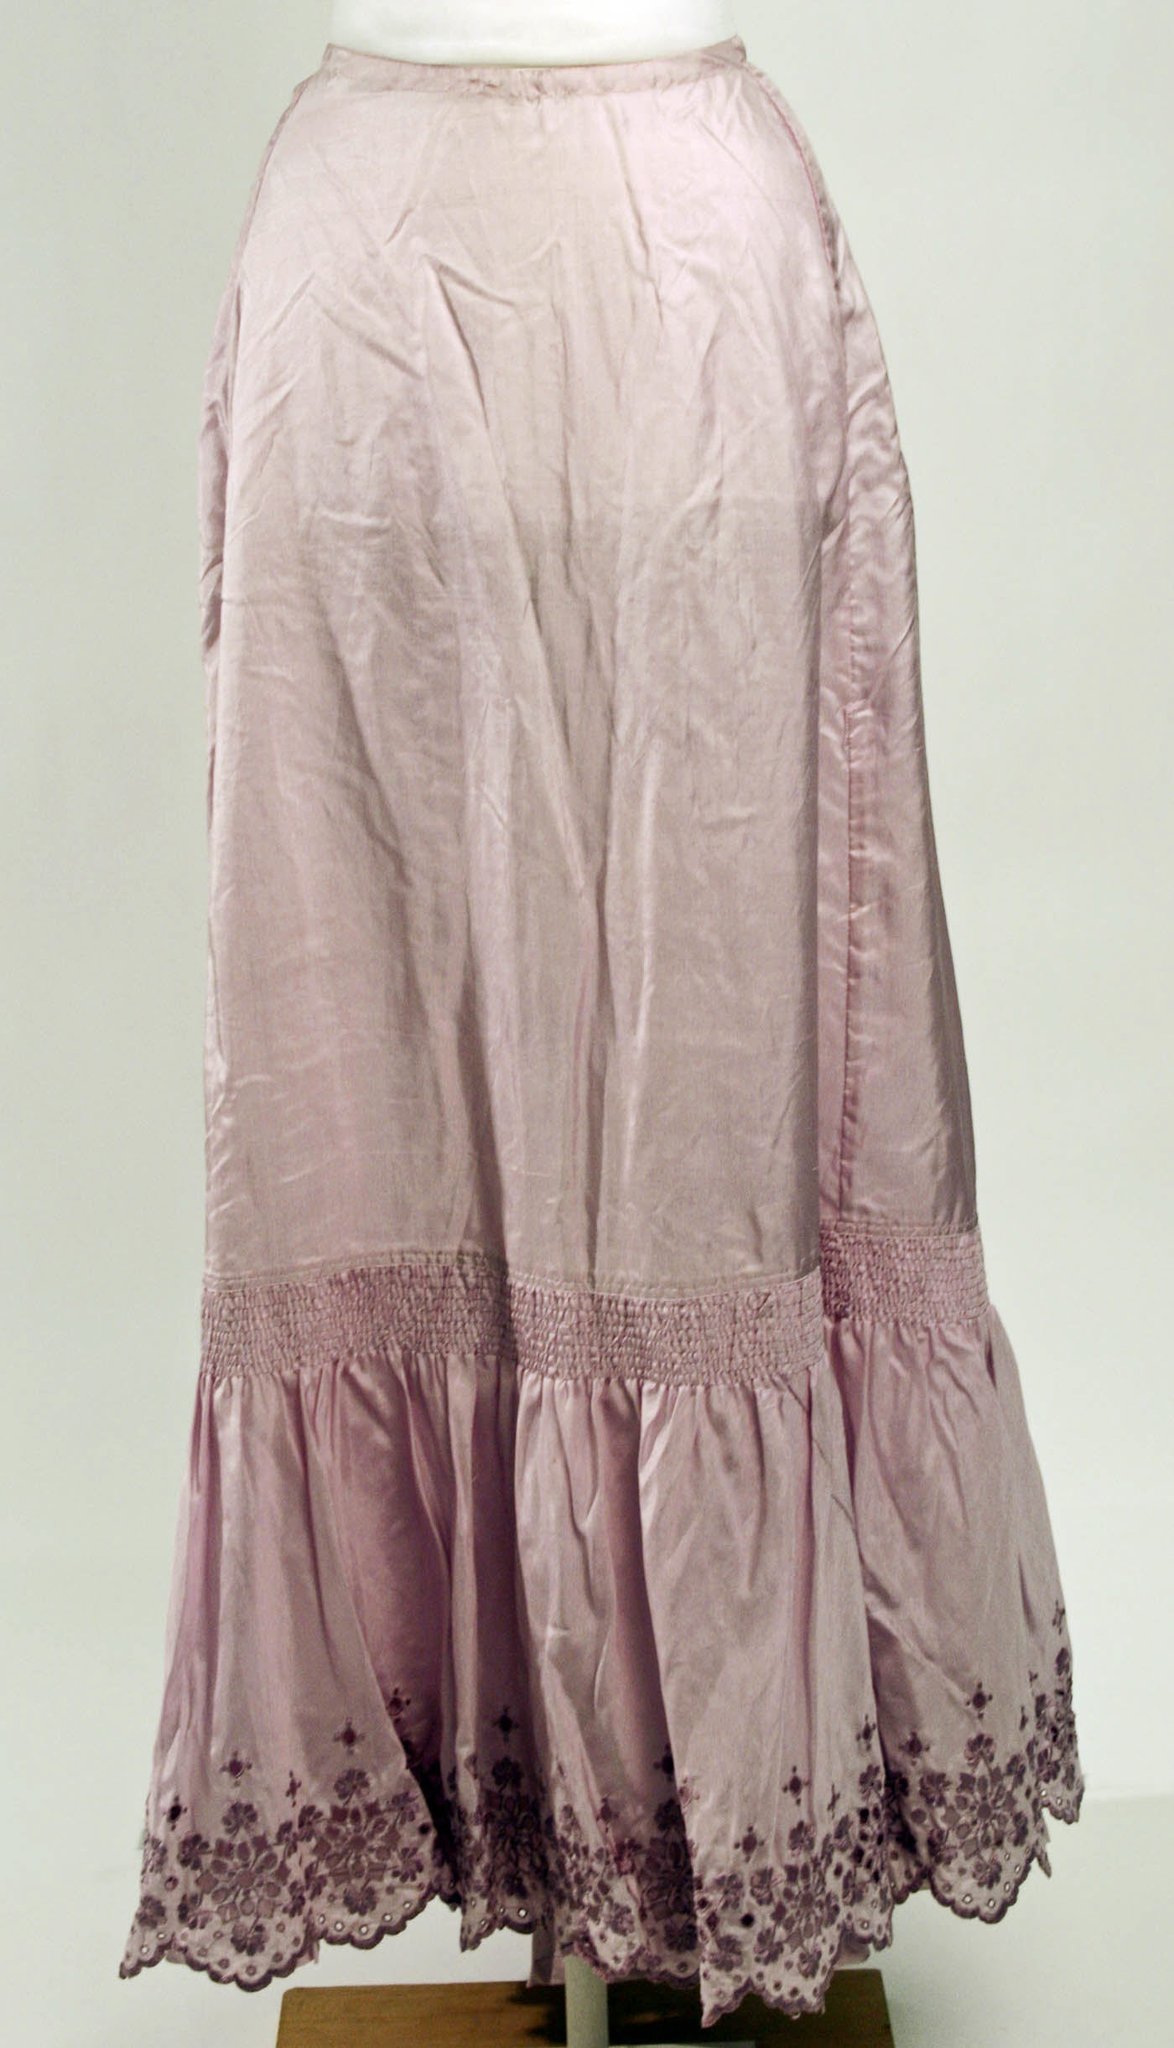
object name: underskirt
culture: american or european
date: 1875-1925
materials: silk